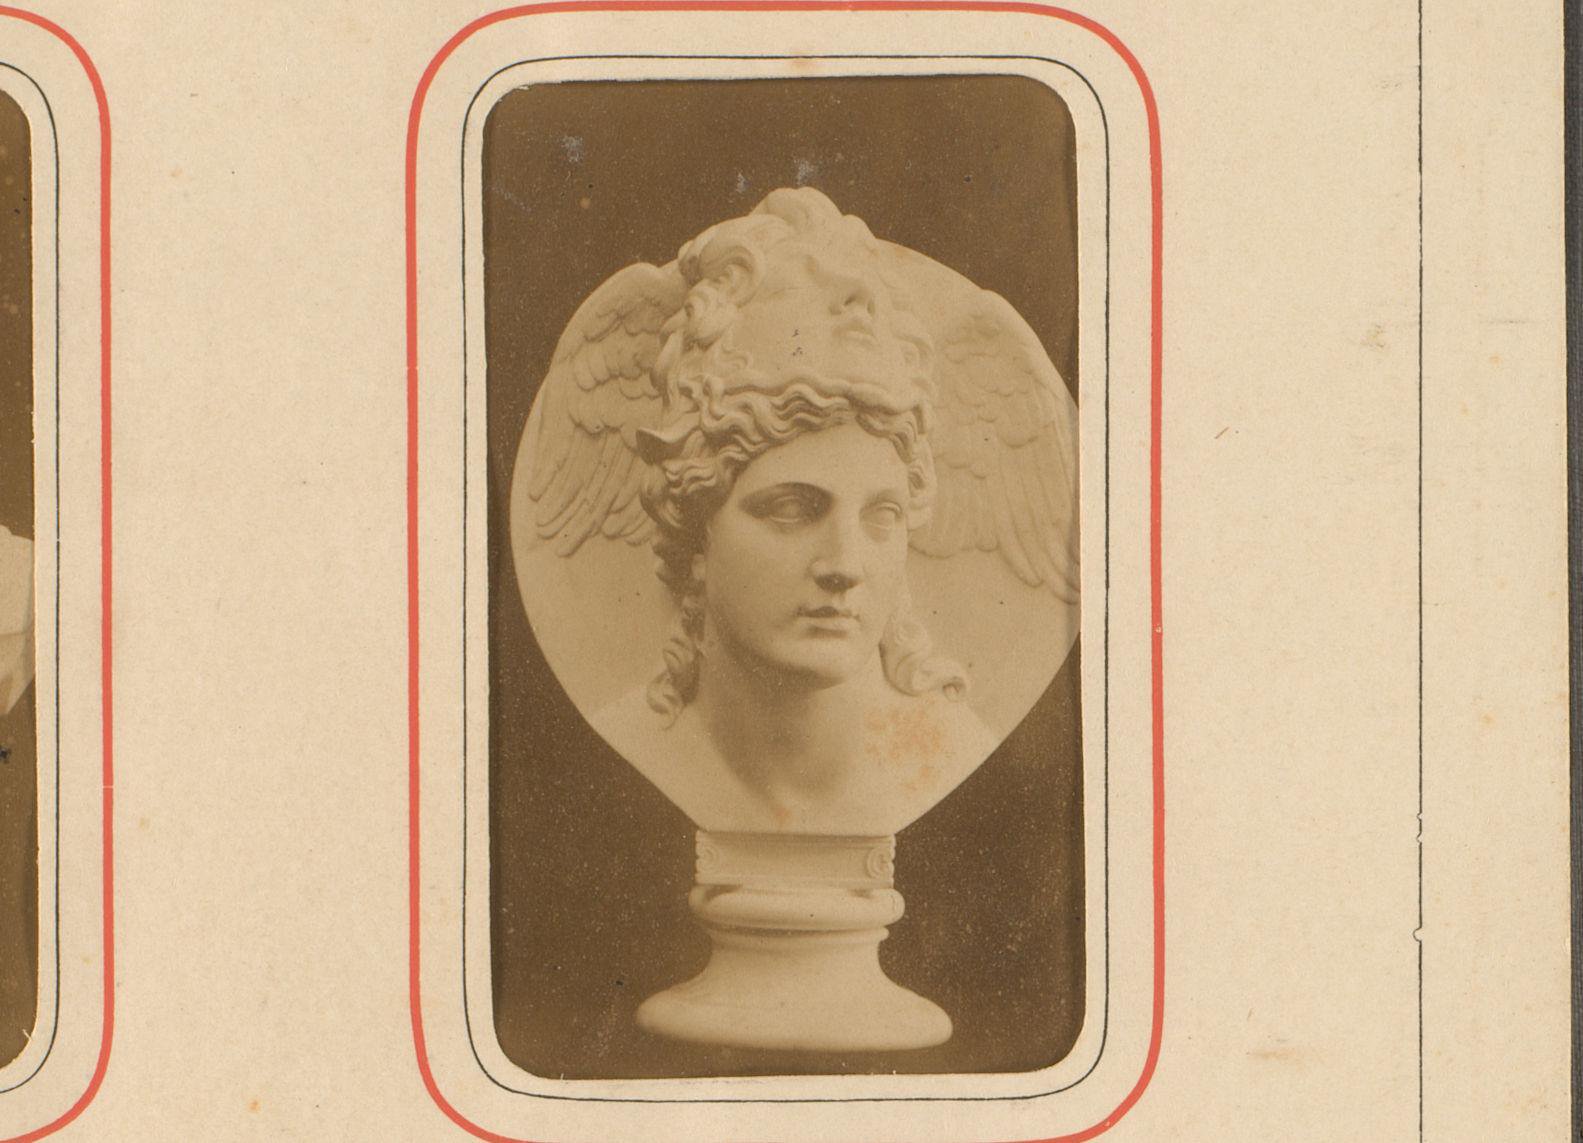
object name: reproduction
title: Minerva Medica, antik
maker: Anonymous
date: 1870-1890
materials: cardboard, paper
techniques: albumen print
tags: sculpture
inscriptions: number: ‘343.’